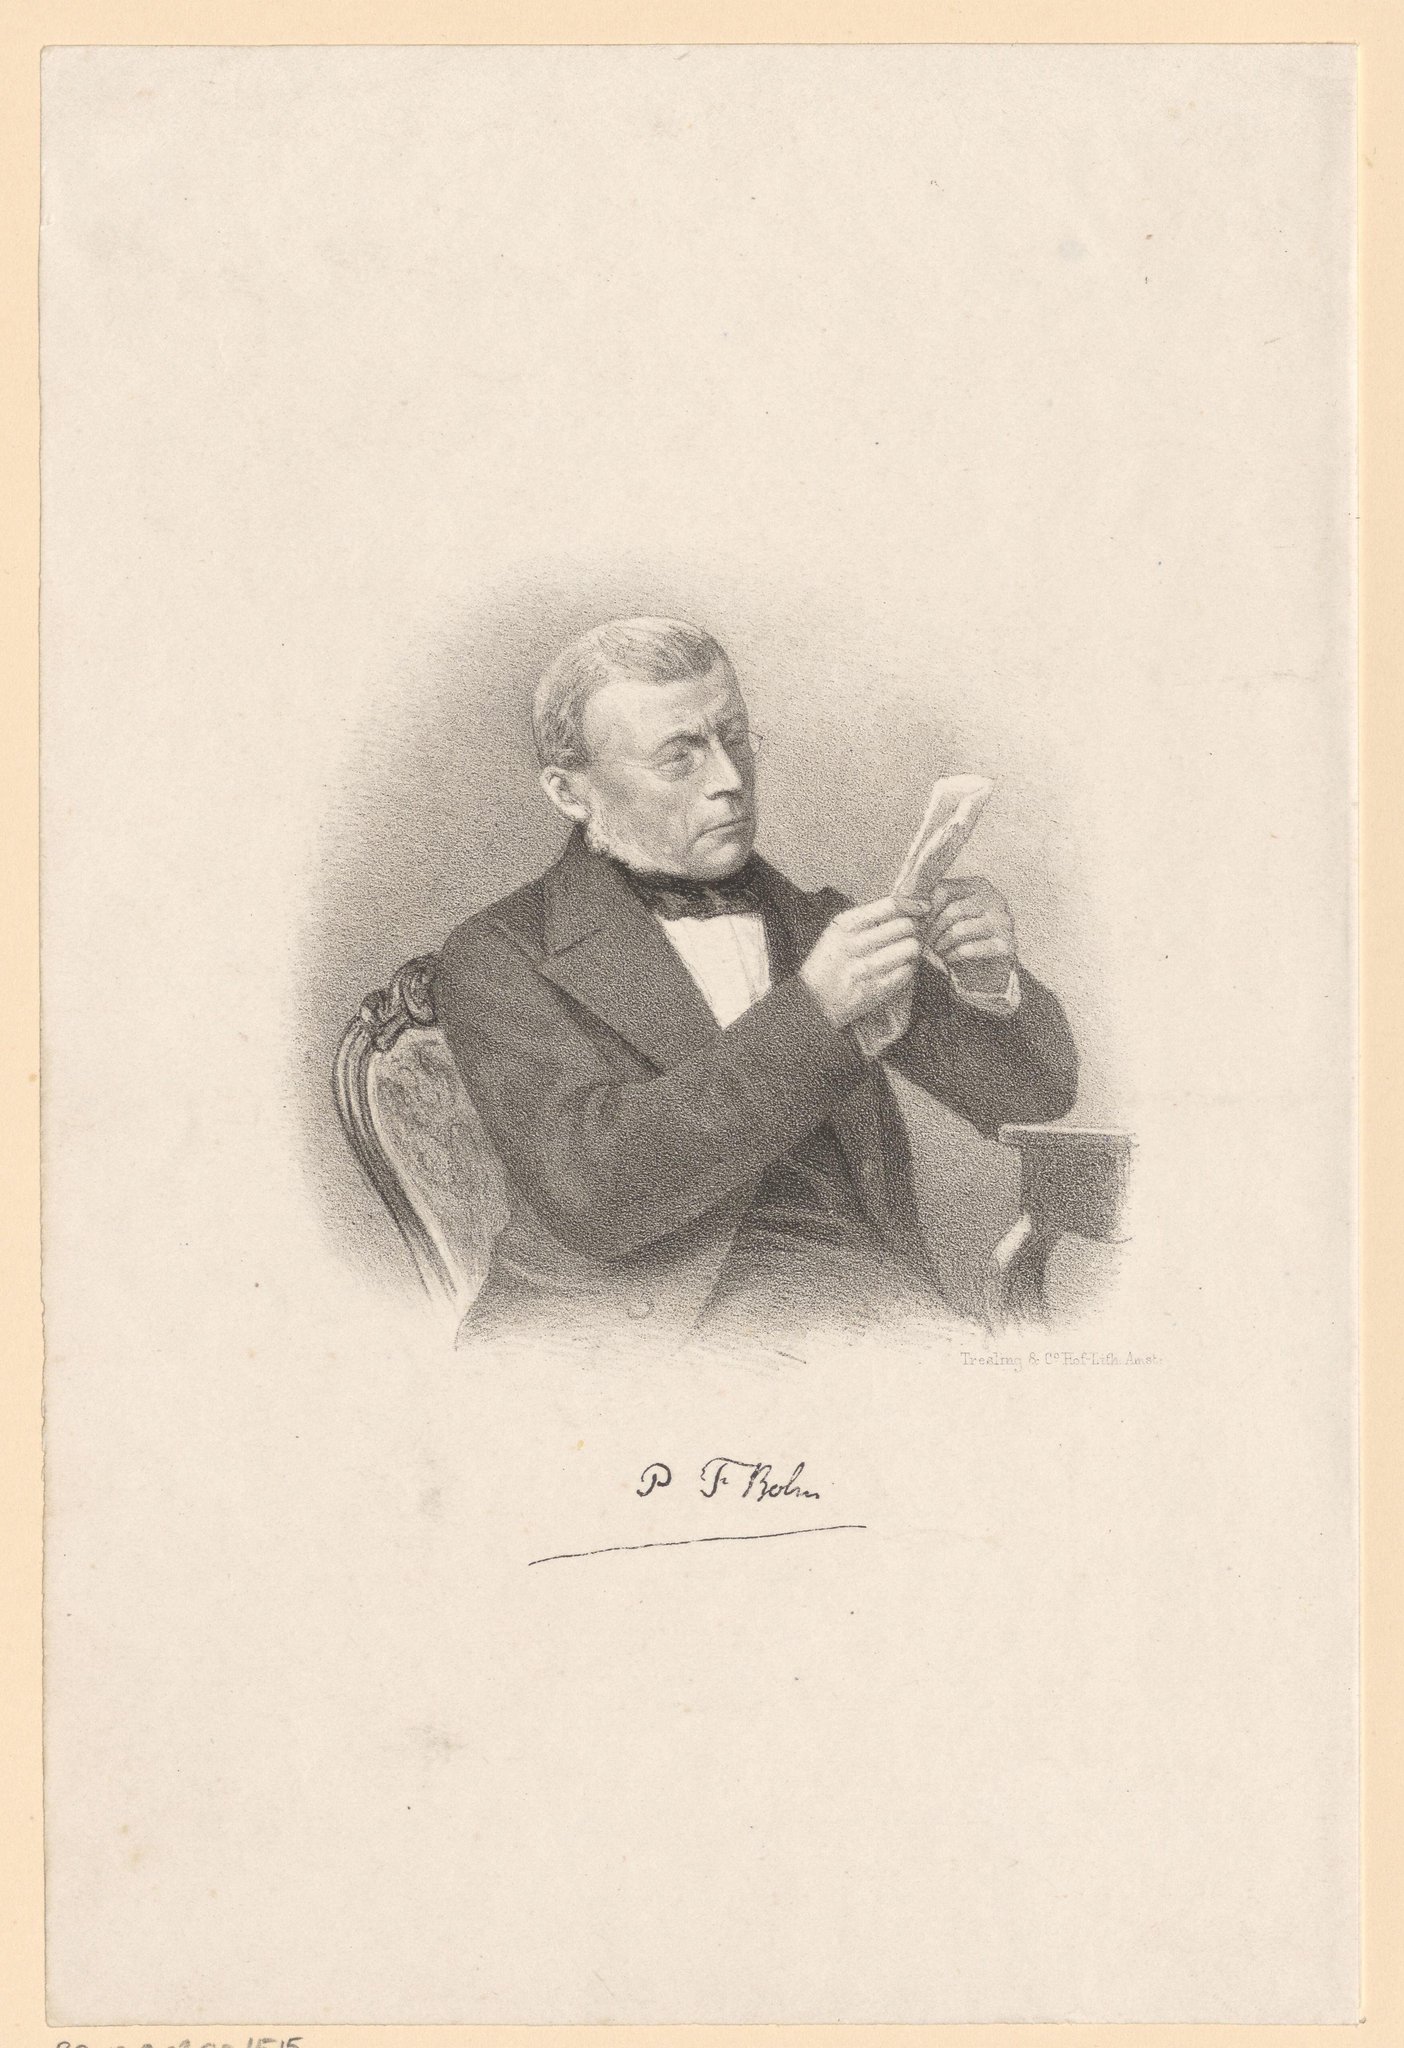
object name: print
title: Portret van Pieter François Bohn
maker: Anonymous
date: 1858-1899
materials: paper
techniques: lithograph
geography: amsterdam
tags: haarlem, historical persons, publishing, publisher